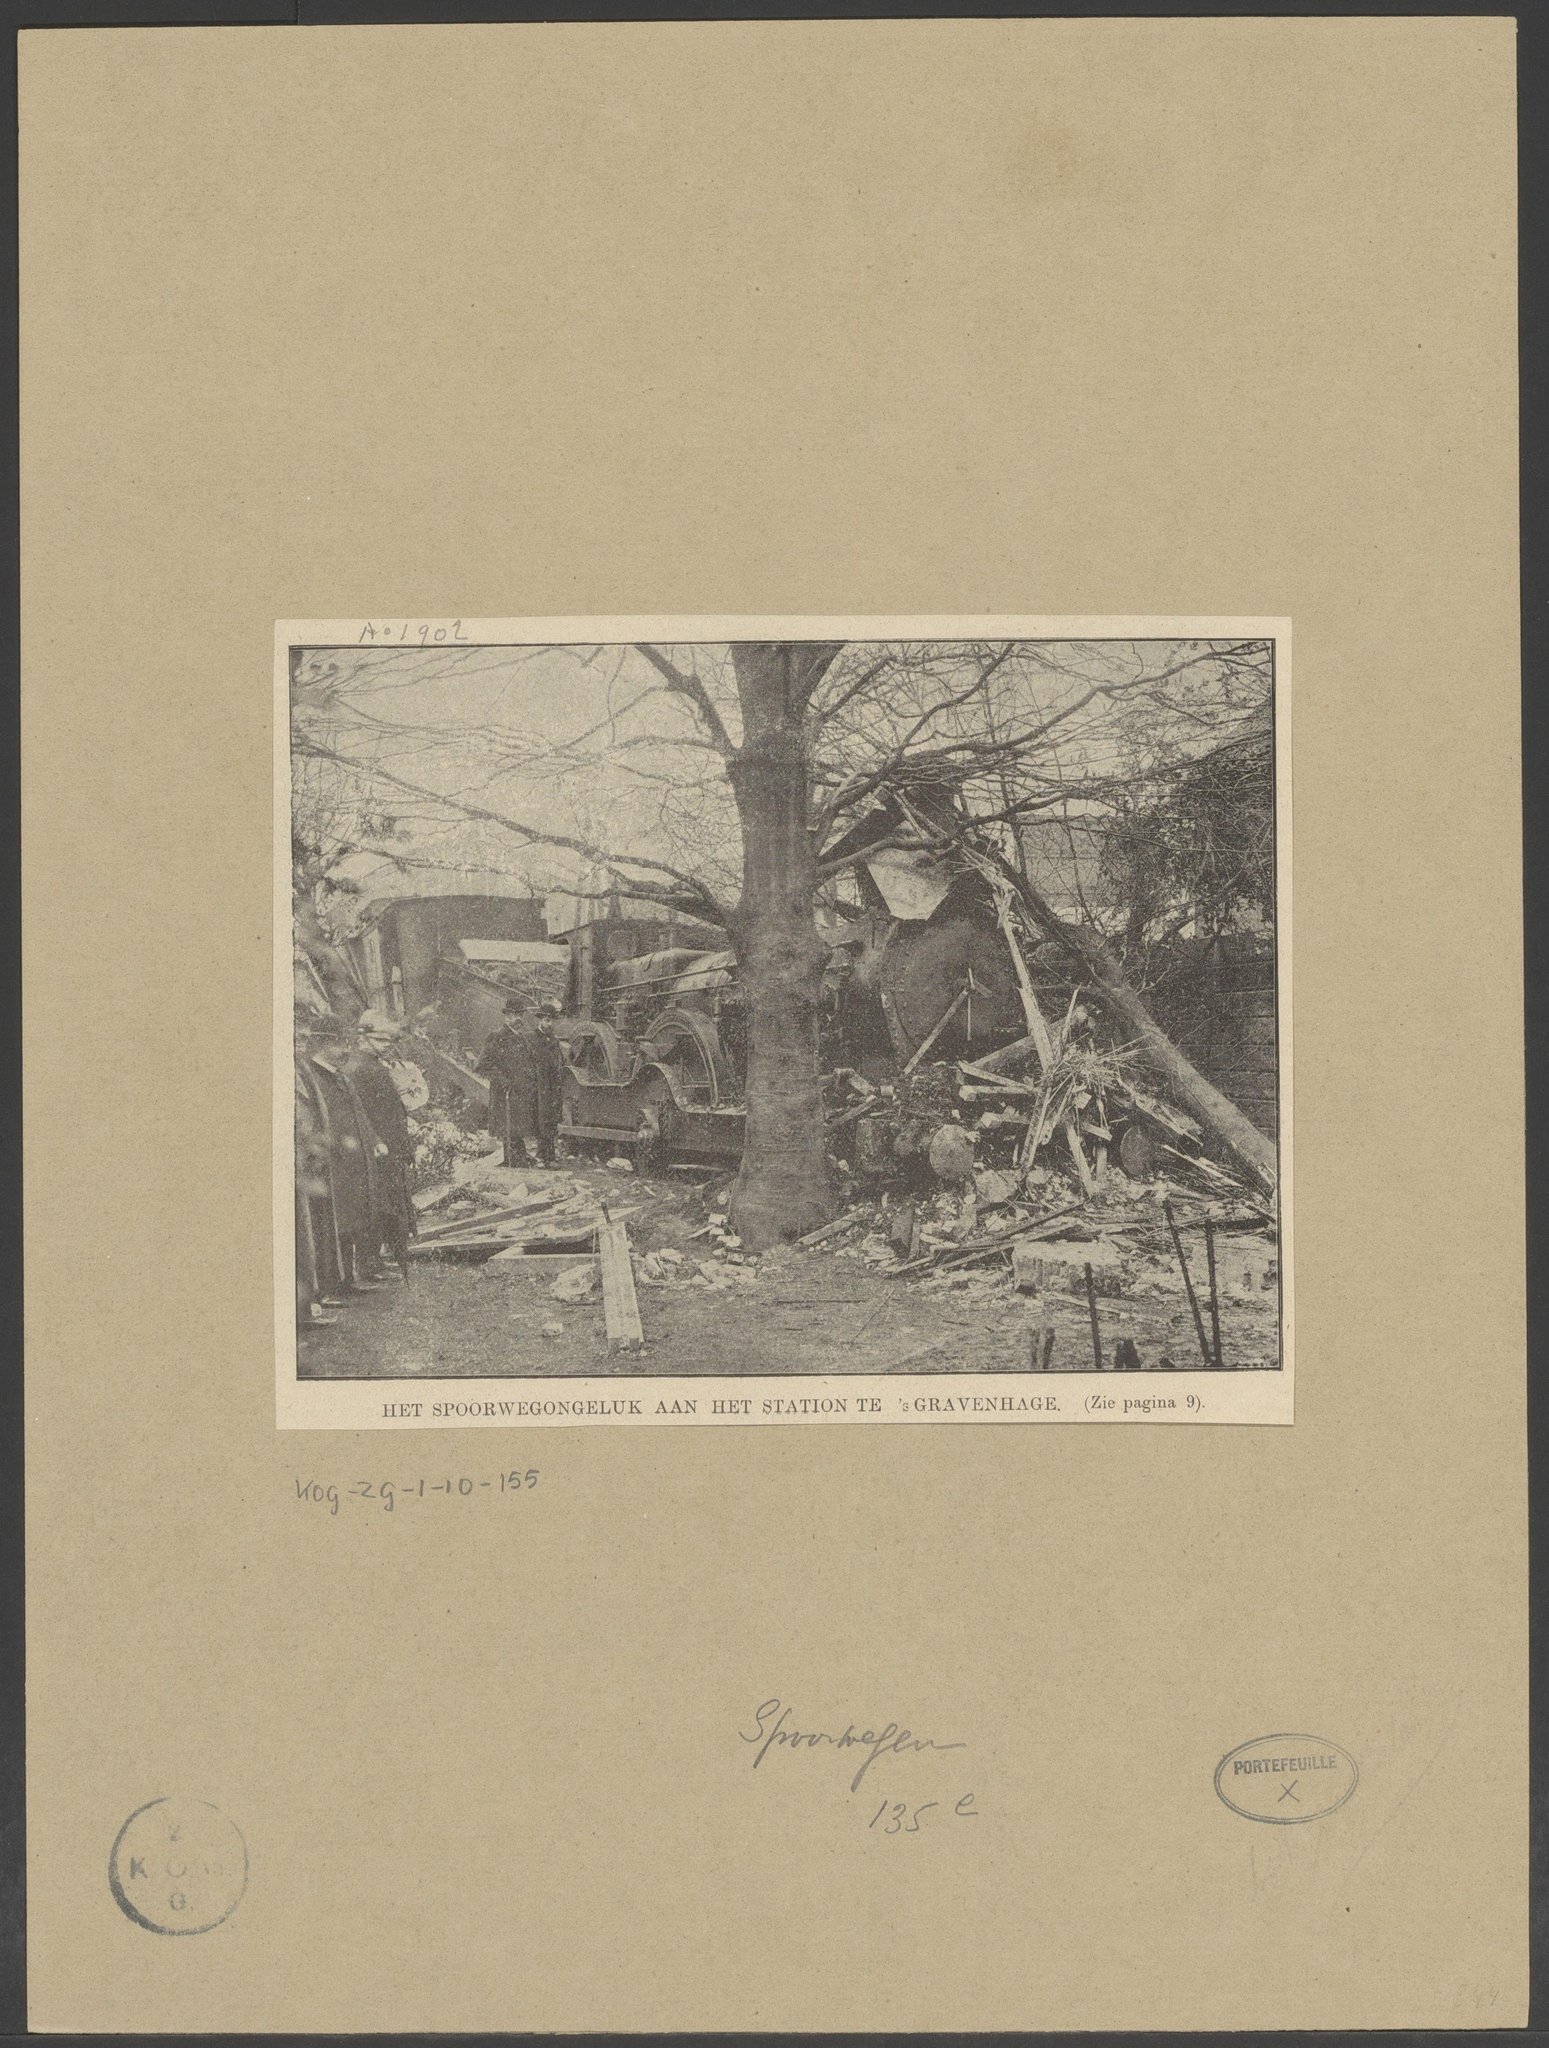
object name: photomechanical print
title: Treinongeluk waarbij een locomotief een tuin in is gereden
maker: Anonymous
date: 1902-1904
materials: paper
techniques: letterpress printing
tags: locomotive, railway-accident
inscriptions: collector's mark: Lugt 1641, stamp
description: Spoorwegongeluk van 18 januari 1902 bij Station Staatsspoor te Den Haag. Nadat de remmen niet blijken te werken wordt de handrem hard aangetrokken, maar de trein komt niet tot stilstand. Uiteindelijk eindigt de trein in een tuin. Bij het ongeluk zijn er geen doden gevallen. Rechtsonder de tekst: (Zie pagina 9). Onderwerpsrubrieken binnen de Atlas Zeden en Gewoonten: Handel, nijverheid en verkeer, Vervoermiddelen te land en te water, vervoermiddelen te land, Spoorwegen.